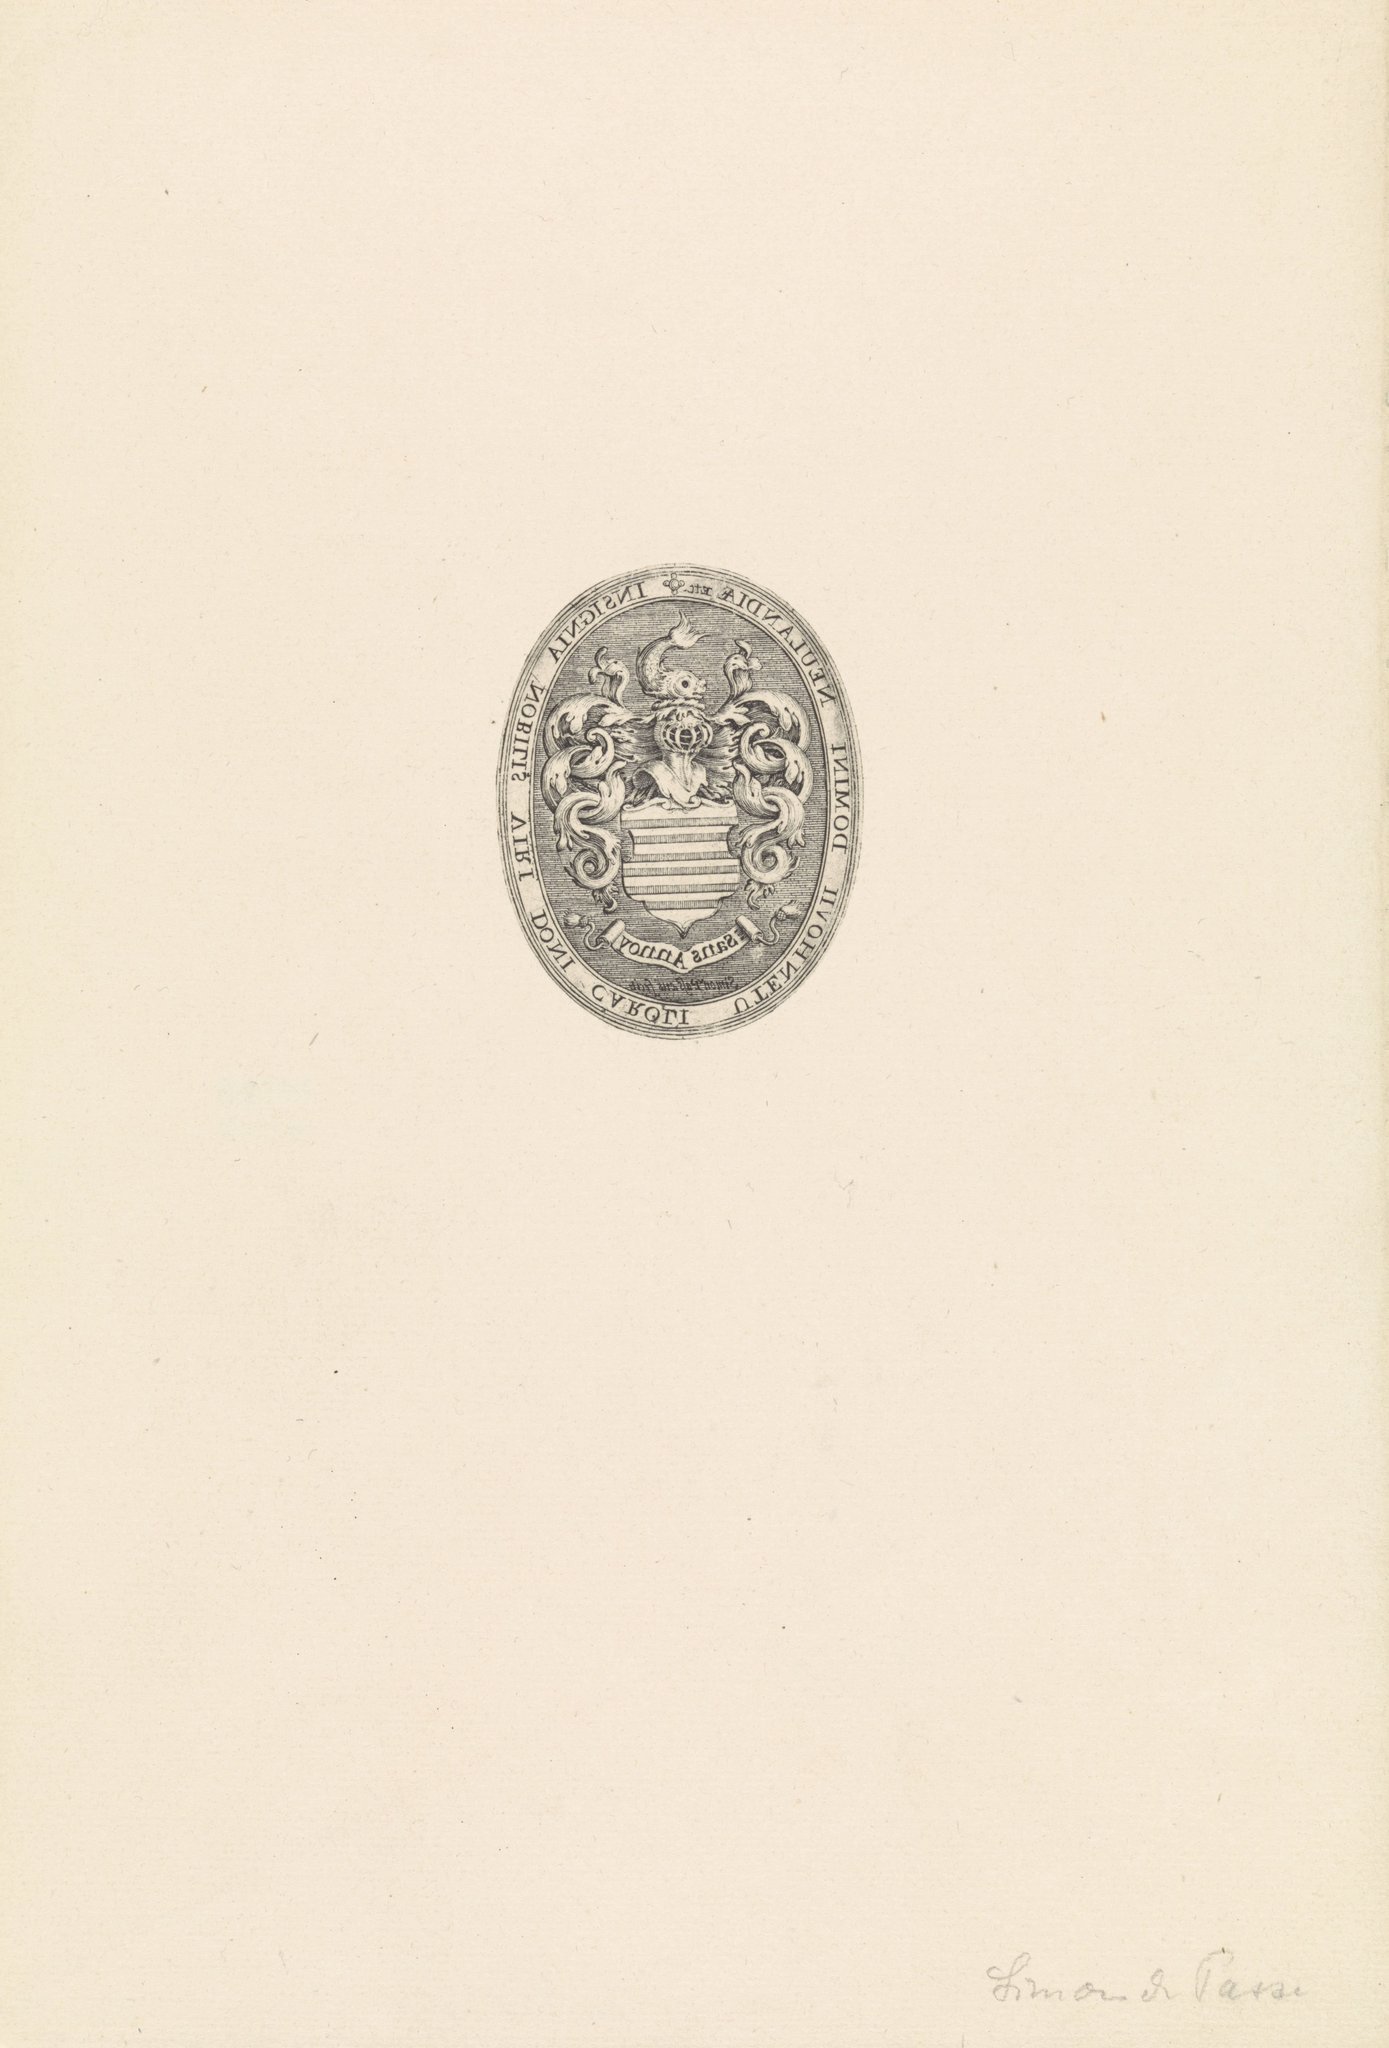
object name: print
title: Wapenschild van Carolus van Utenhoven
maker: simon van de passe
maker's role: print maker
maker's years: 1595-1647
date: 1605-1647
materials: paper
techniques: engraving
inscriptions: collector's mark: Lugt 2166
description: Medaillon met het wapenschild van Carolus van Utenhoven, eronder op een banderol zijn devies in het Latijn, in spiegelbeeld. De omlijsting heeft een randschrift in het Latijn, in spiegelbeeld. Op de voorzijde van de medaille het portret van Carolus van Utenhoven.